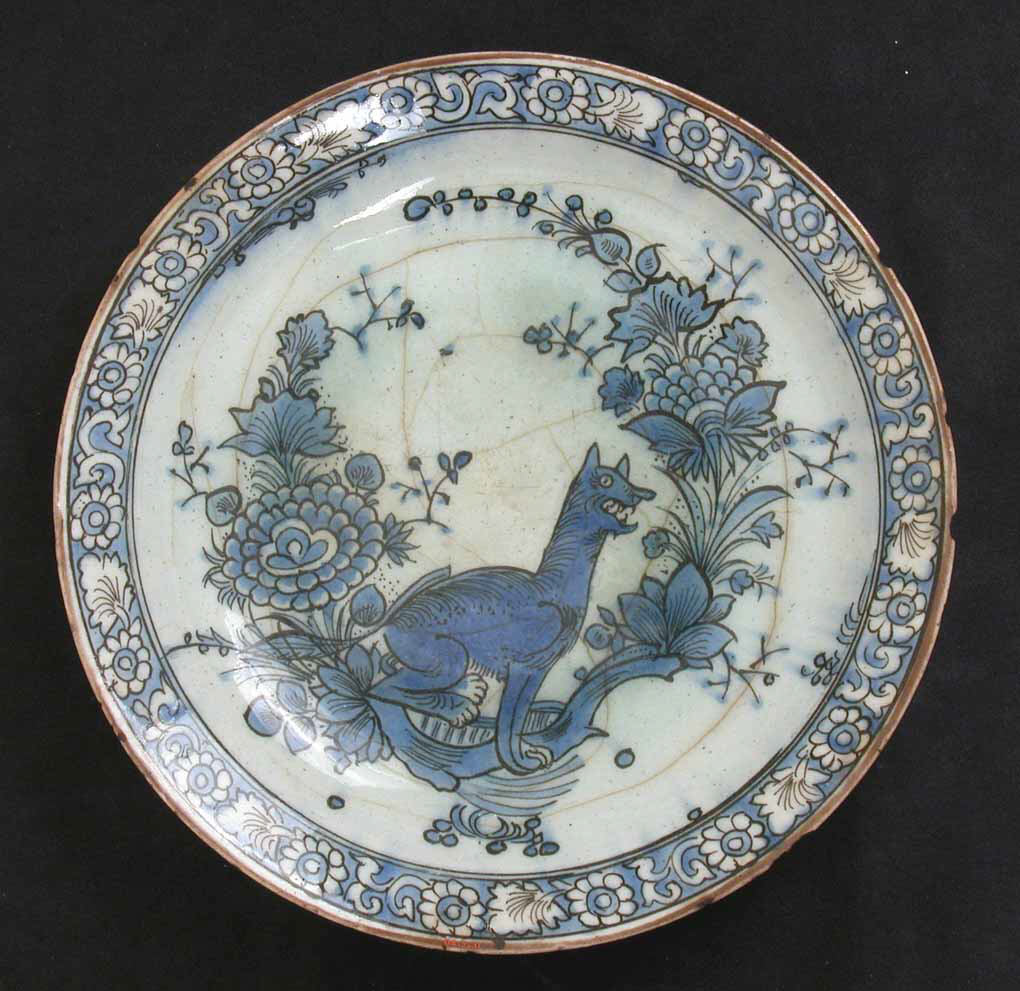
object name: dish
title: Dish with Fox and Vegetation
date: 1701-1900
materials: glaze, stonepaste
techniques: painting, polychrome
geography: iran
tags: foxes,flowers,leaves